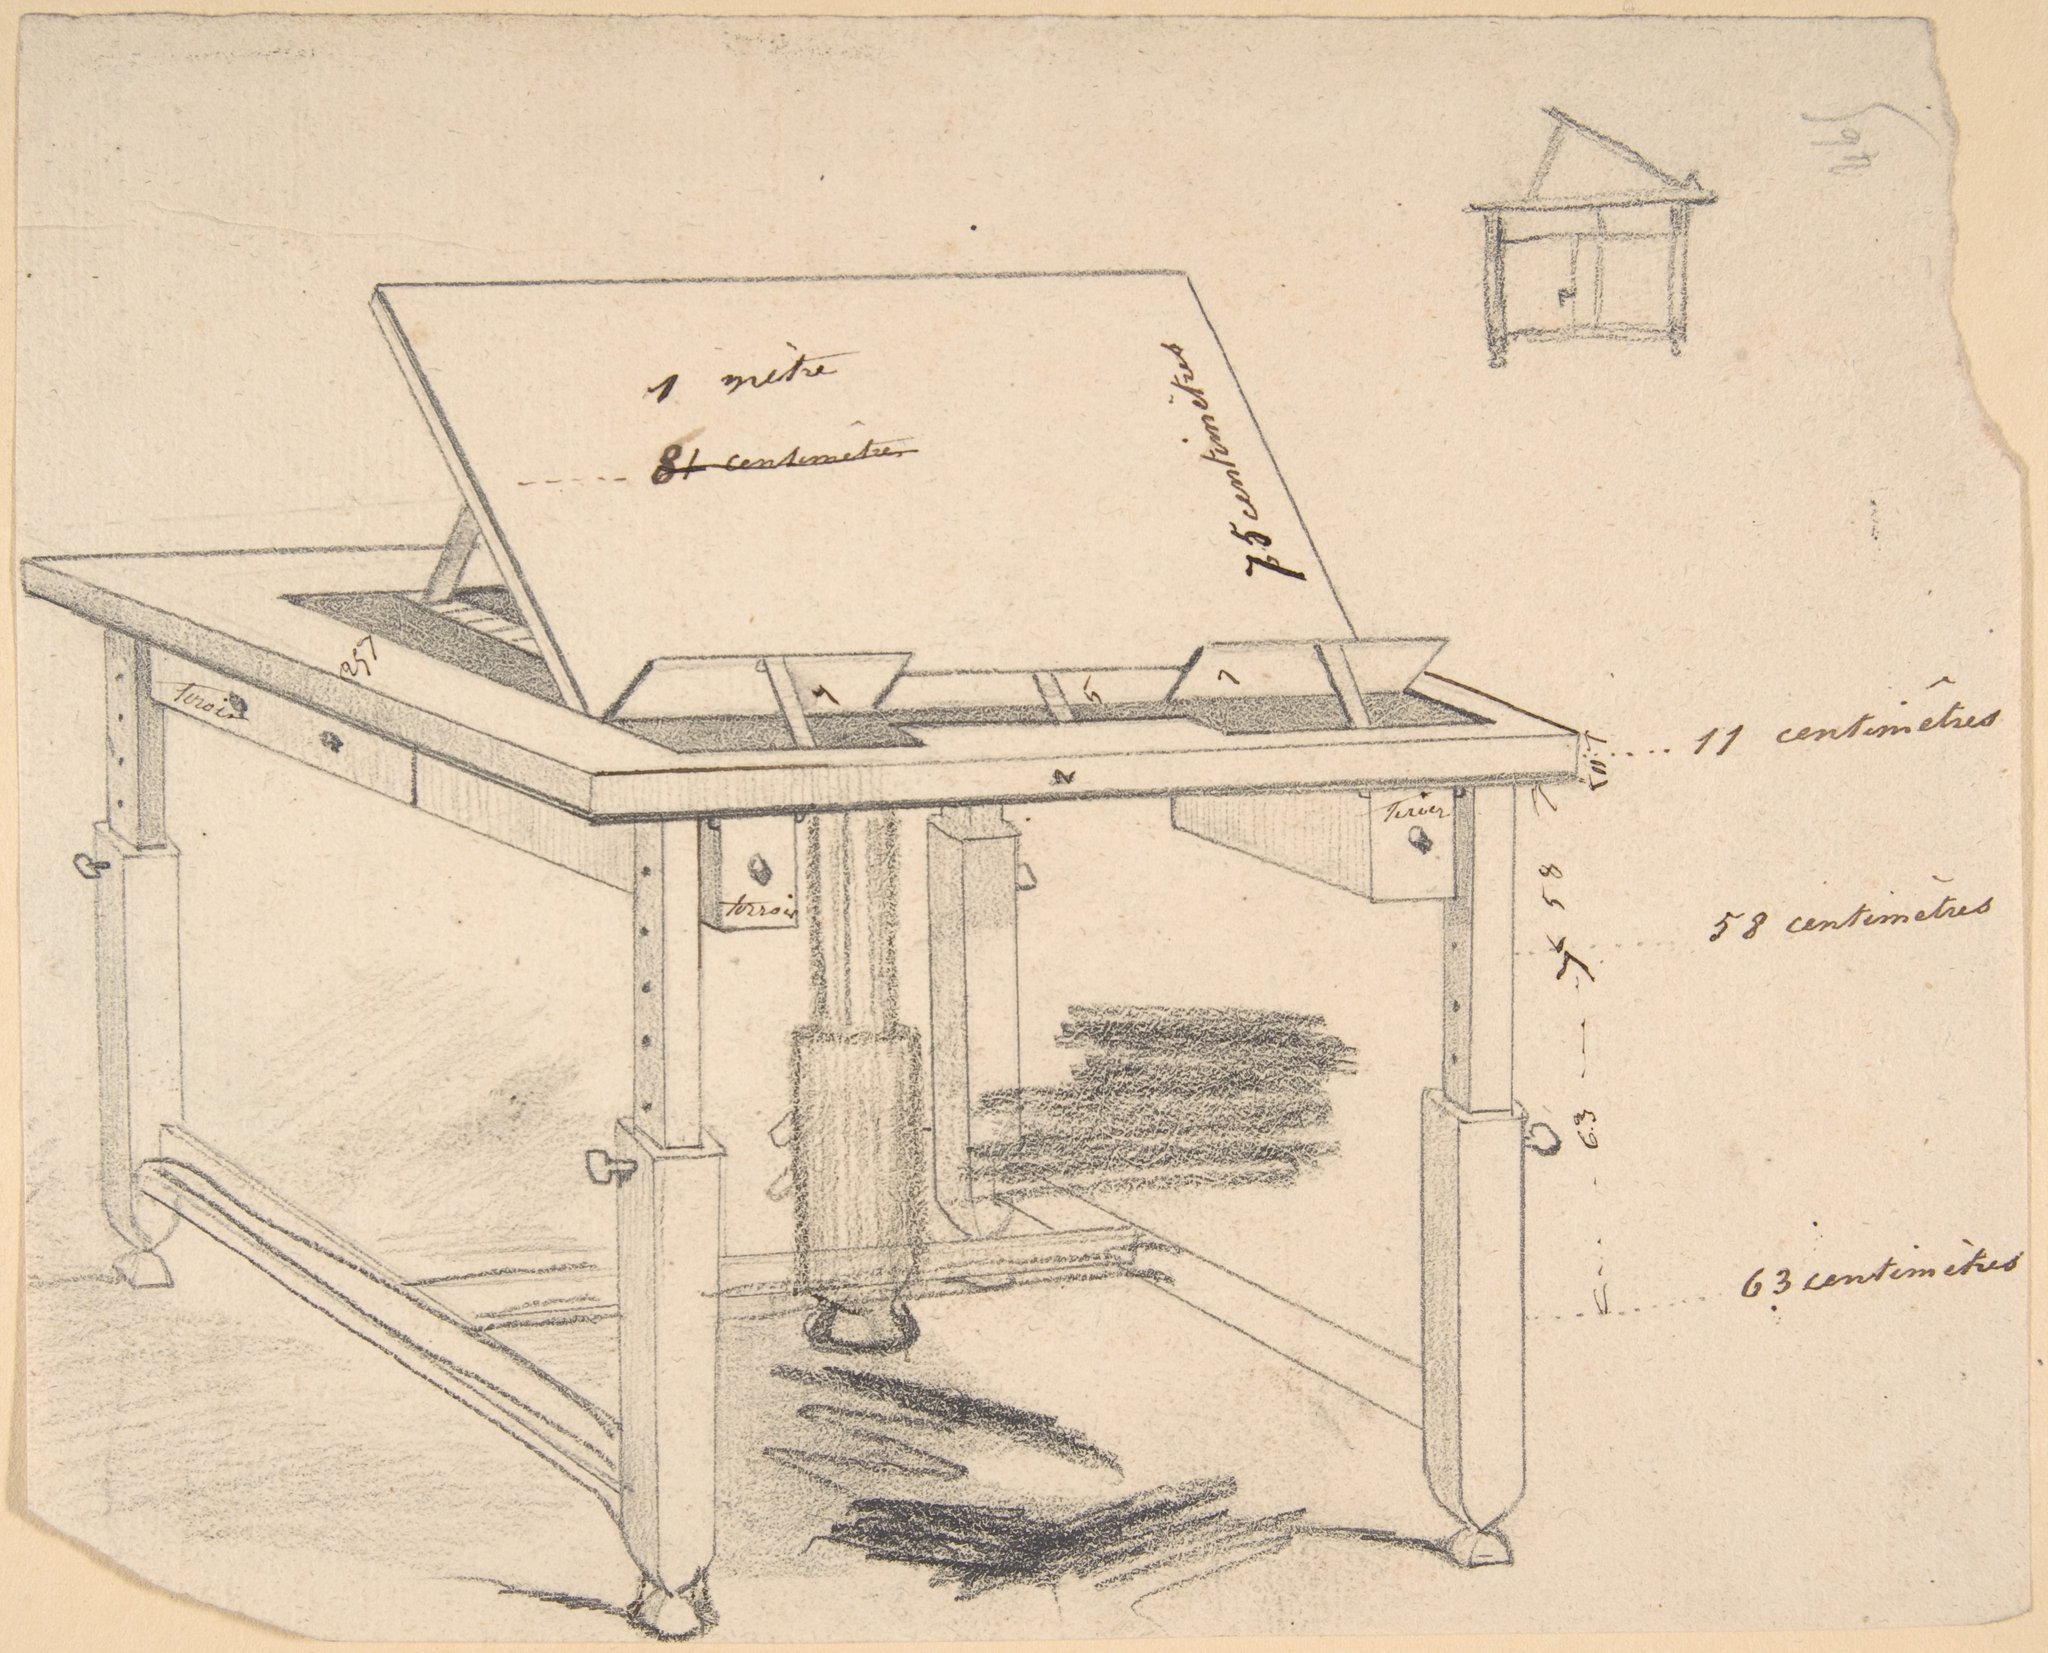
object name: drawing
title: Project for a work table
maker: félicien rops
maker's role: artist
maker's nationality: belgian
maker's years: 1833-1898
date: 1833-1898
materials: graphite, ink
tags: tables